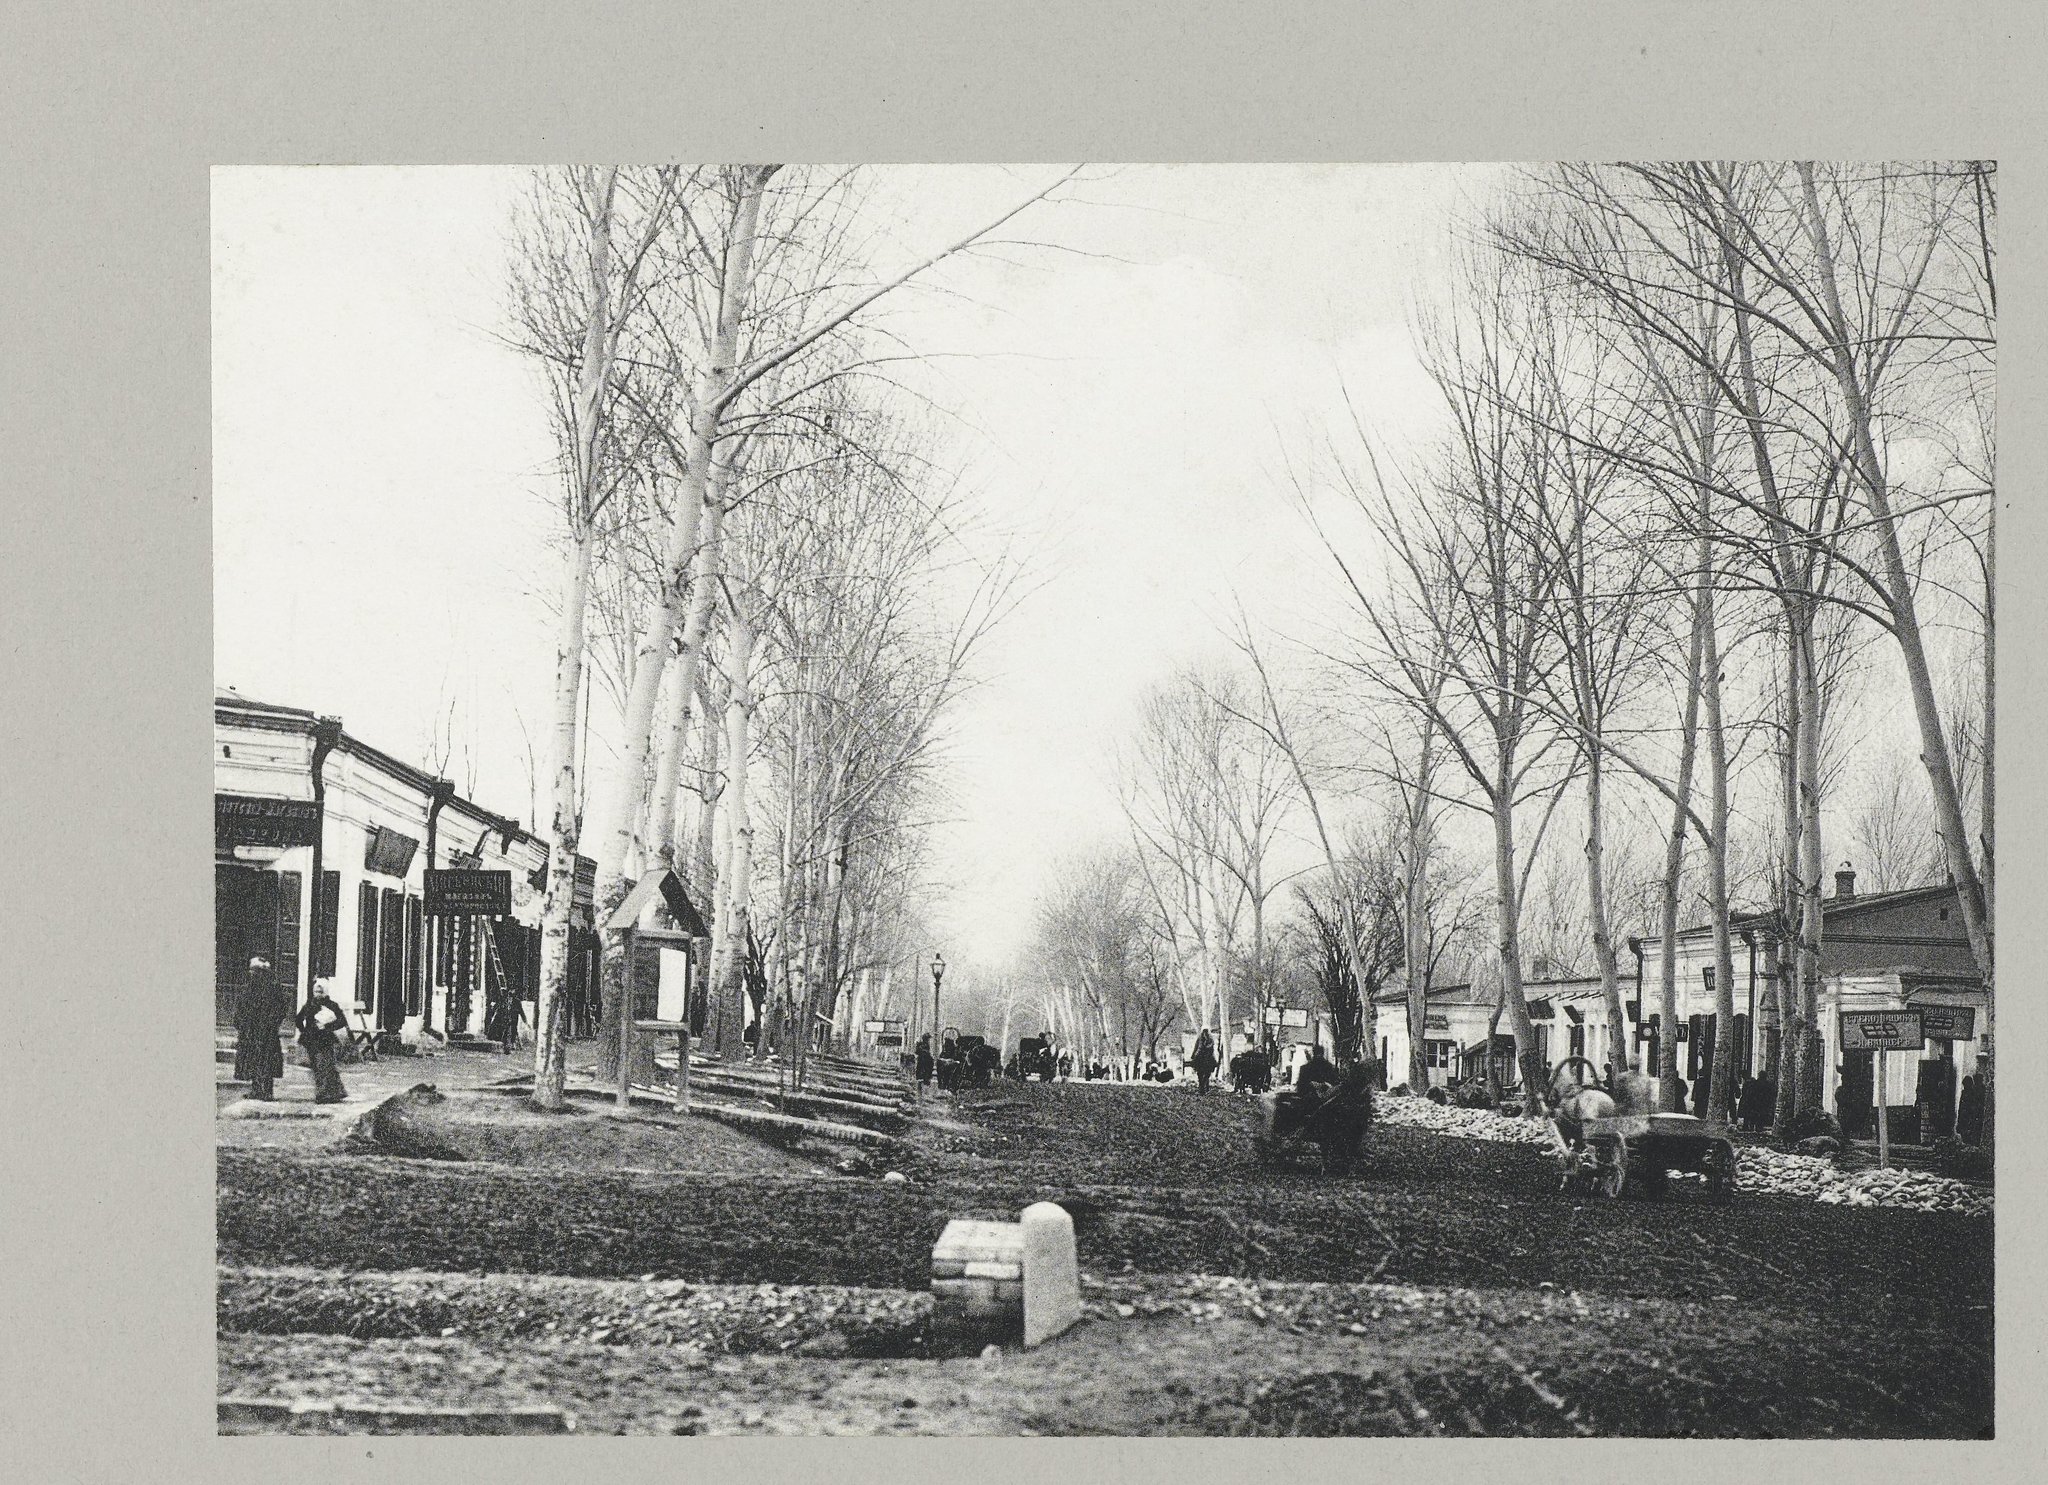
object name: photomechanical print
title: Straat in de Russische wijk te Samarkand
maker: Anonymous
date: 1895-1915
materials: cardboard, paper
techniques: photograph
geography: samarqand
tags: samarqand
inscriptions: annotation: ‘4. Straat in de Russische wijk te Samarkand.’